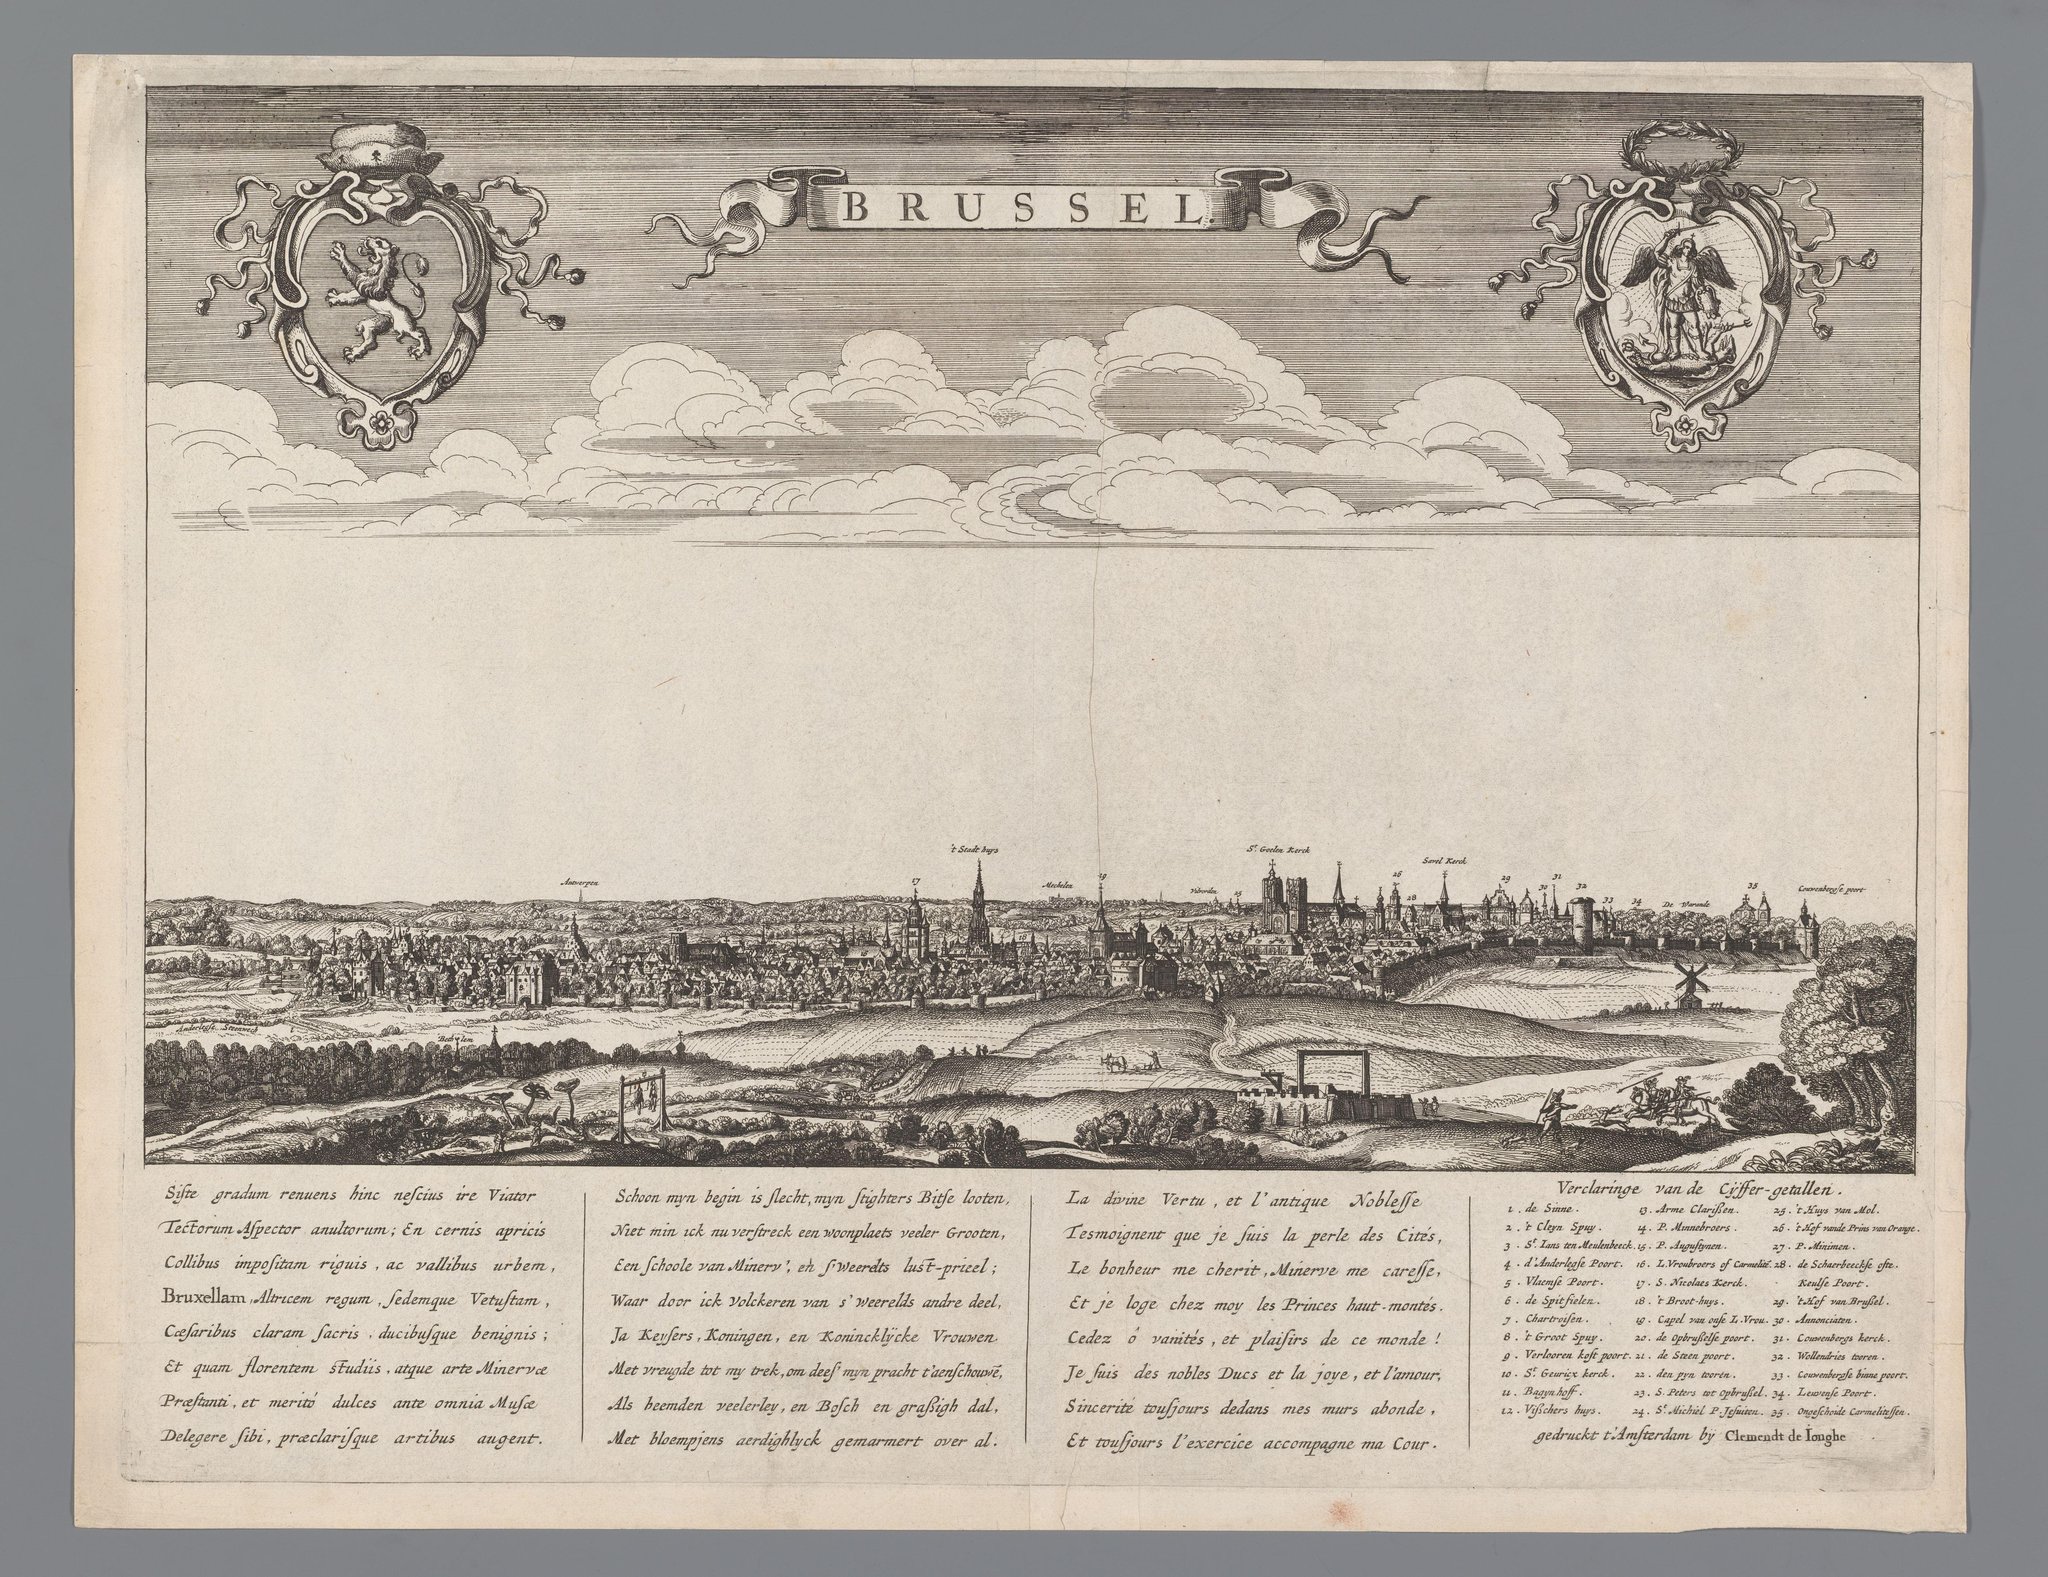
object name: print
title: Brussel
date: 1634-1677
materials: paper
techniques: etching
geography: amsterdam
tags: city-view, and landscape with man-made constructions, brussels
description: Gezicht op Brussel met rechtsonder legenda 1-35.